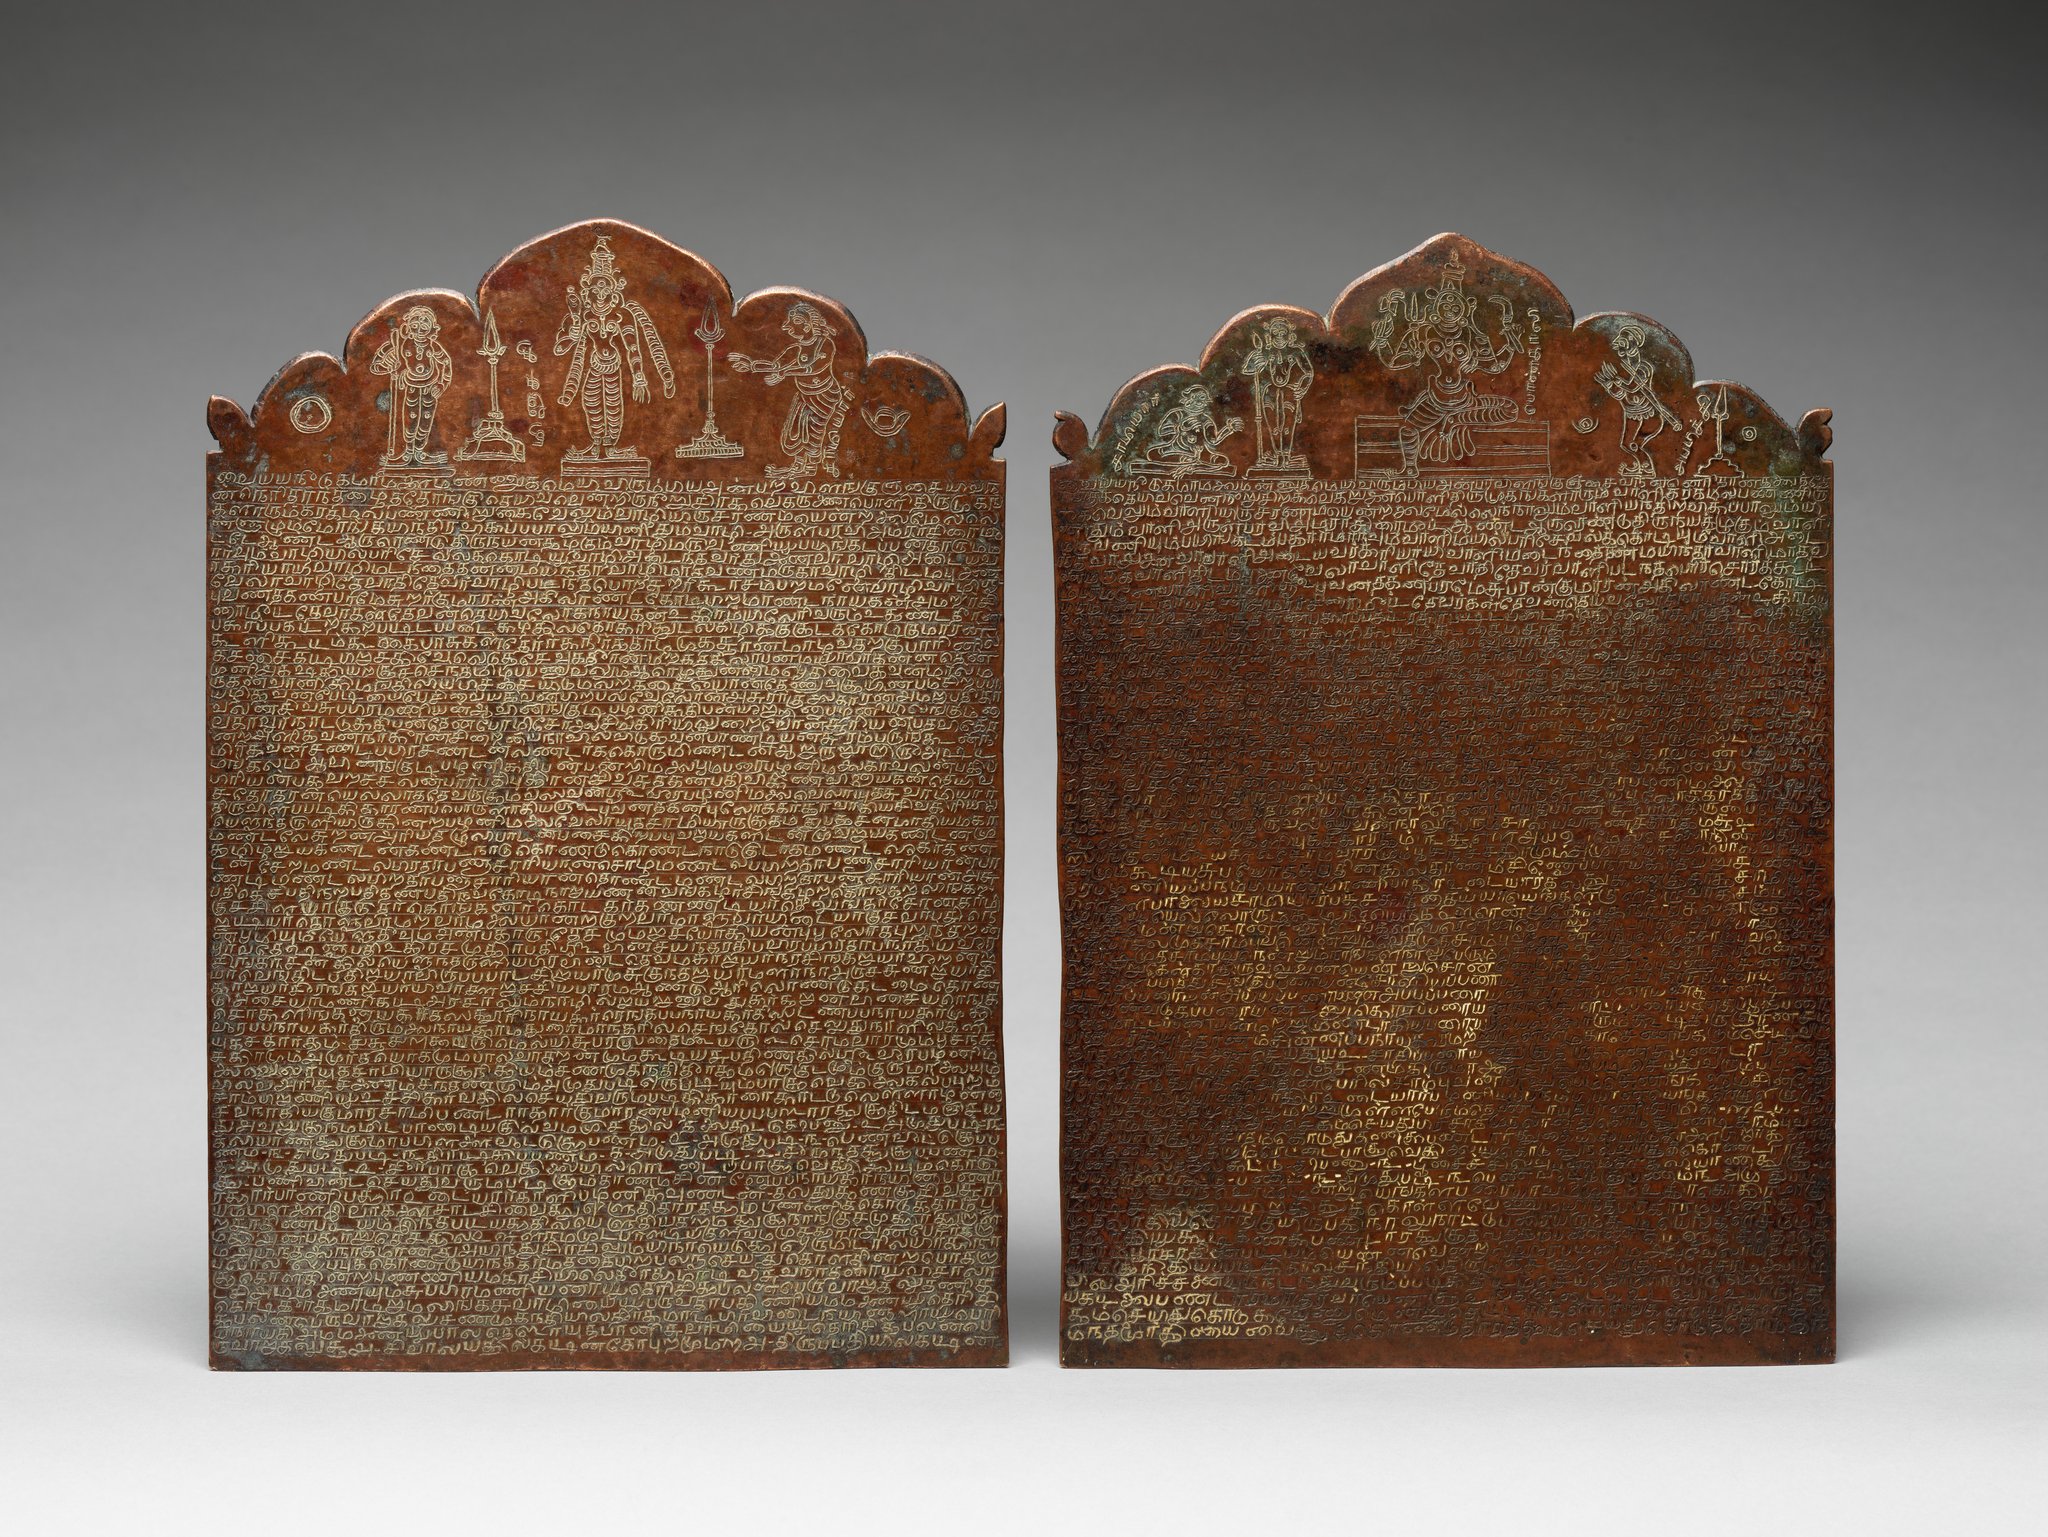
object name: inscription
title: Pair of Copper-Plate Inscriptions with Engraved Designs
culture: tamil nadu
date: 1801-1900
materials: copper